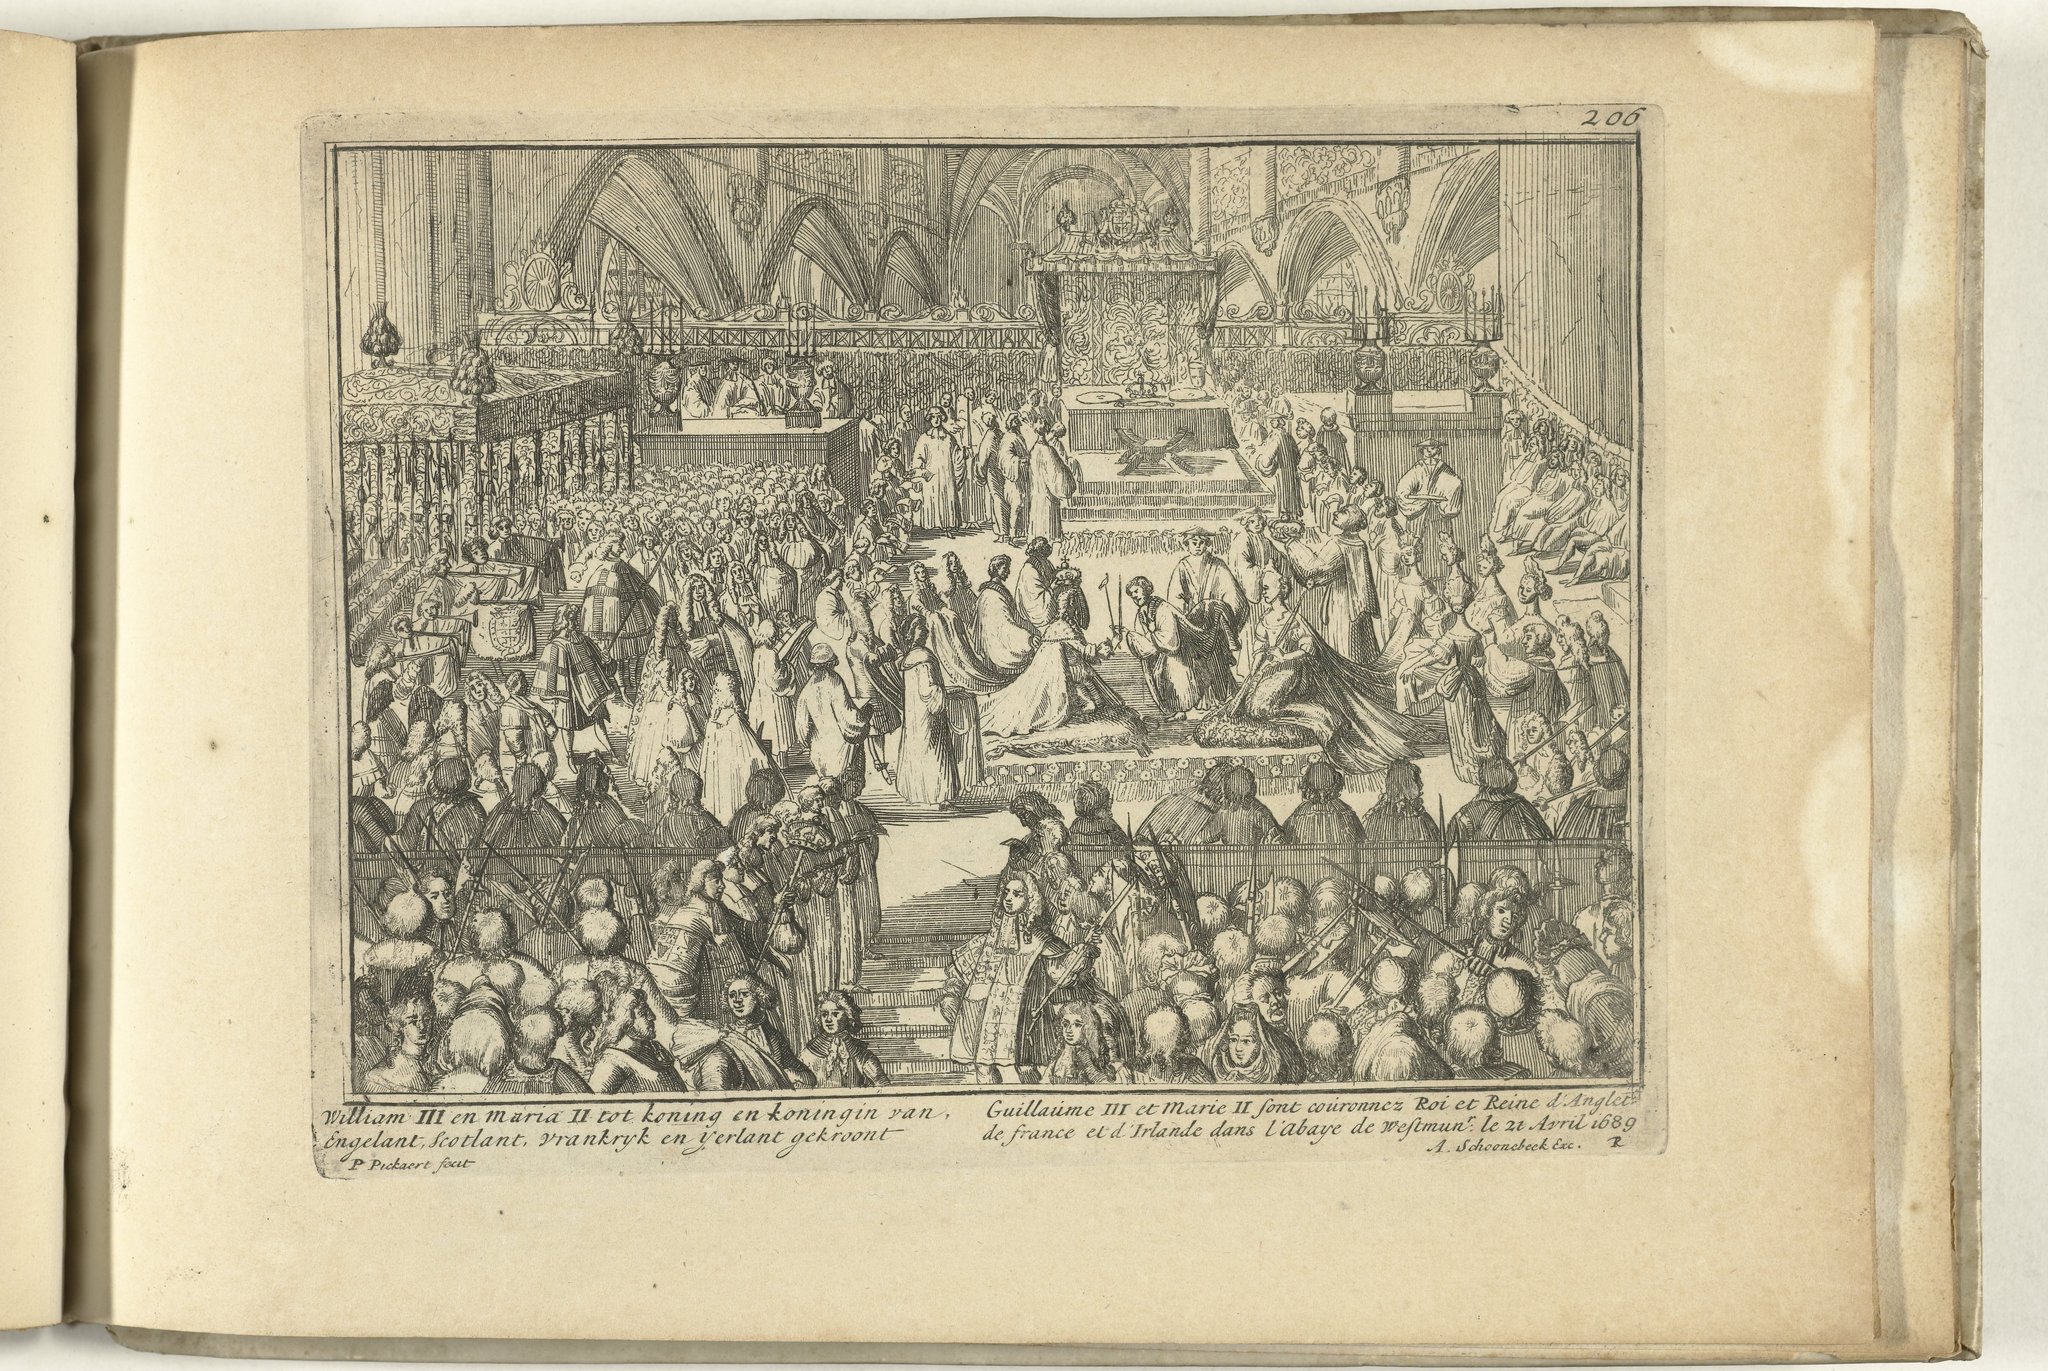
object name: print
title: Engelants schoutoneel verbeeldende de Glorieuse overtogt met het kroonen van William III en Maria II tot Koning en Koningin van groot Brittany en Vrankryk en Yrlant, etc. II Deel.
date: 1689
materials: paper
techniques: etching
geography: amsterdam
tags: the hague, william iii (prince of orange and king of england, scotland, and ireland), london, maria ii stuart (koningin van engeland, schotland en ierland), during the coronation, westminster abbey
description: Kroning van prins Willem III en prinses Maria Stuart tot koning en koningin van Engeland, in Westminster Abbey op 21 april 1689. Genummerd rechtsboven: 206. Plaat R in de serie 'Engelants schouwtoneel' over de Glorious Revolution 1688-1689 (tweede deel). Met onderschriften in het Nederlands en Frans.